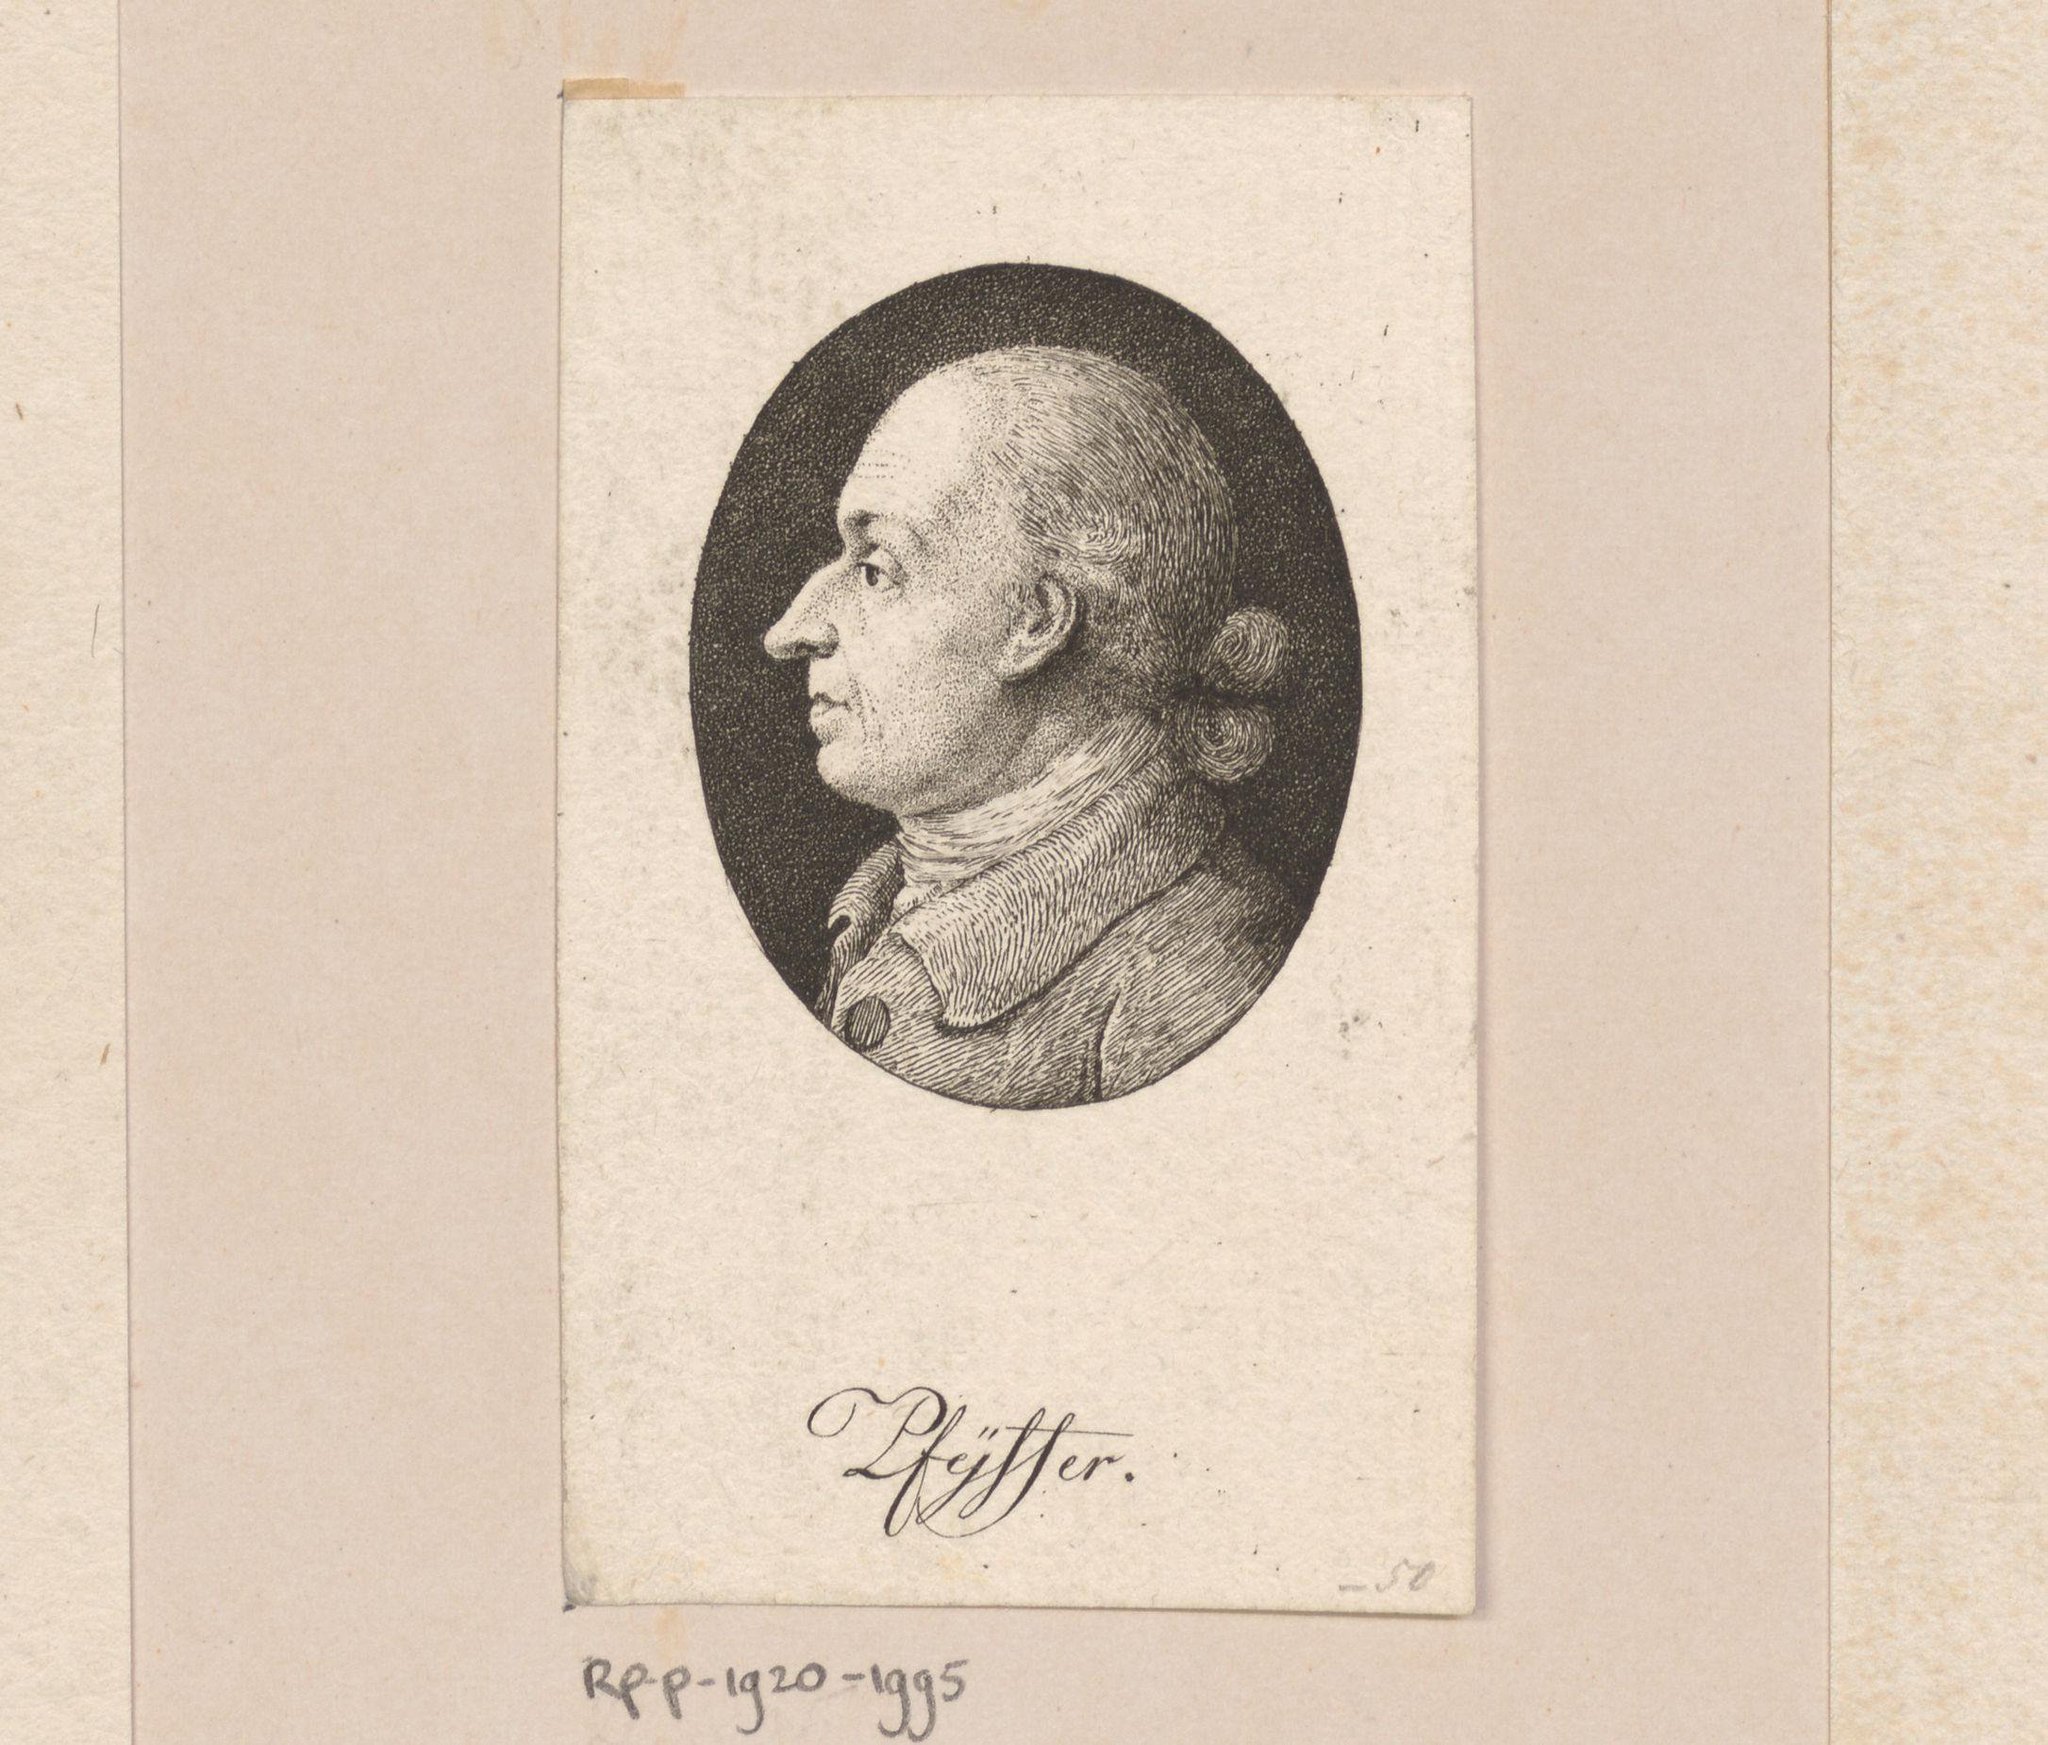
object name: print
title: Portret van Franz Ludwig Pfyffer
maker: Anonymous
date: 1750-1824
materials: paper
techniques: engraving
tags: adult man, historical persons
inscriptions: collector's mark: Lugt 2228